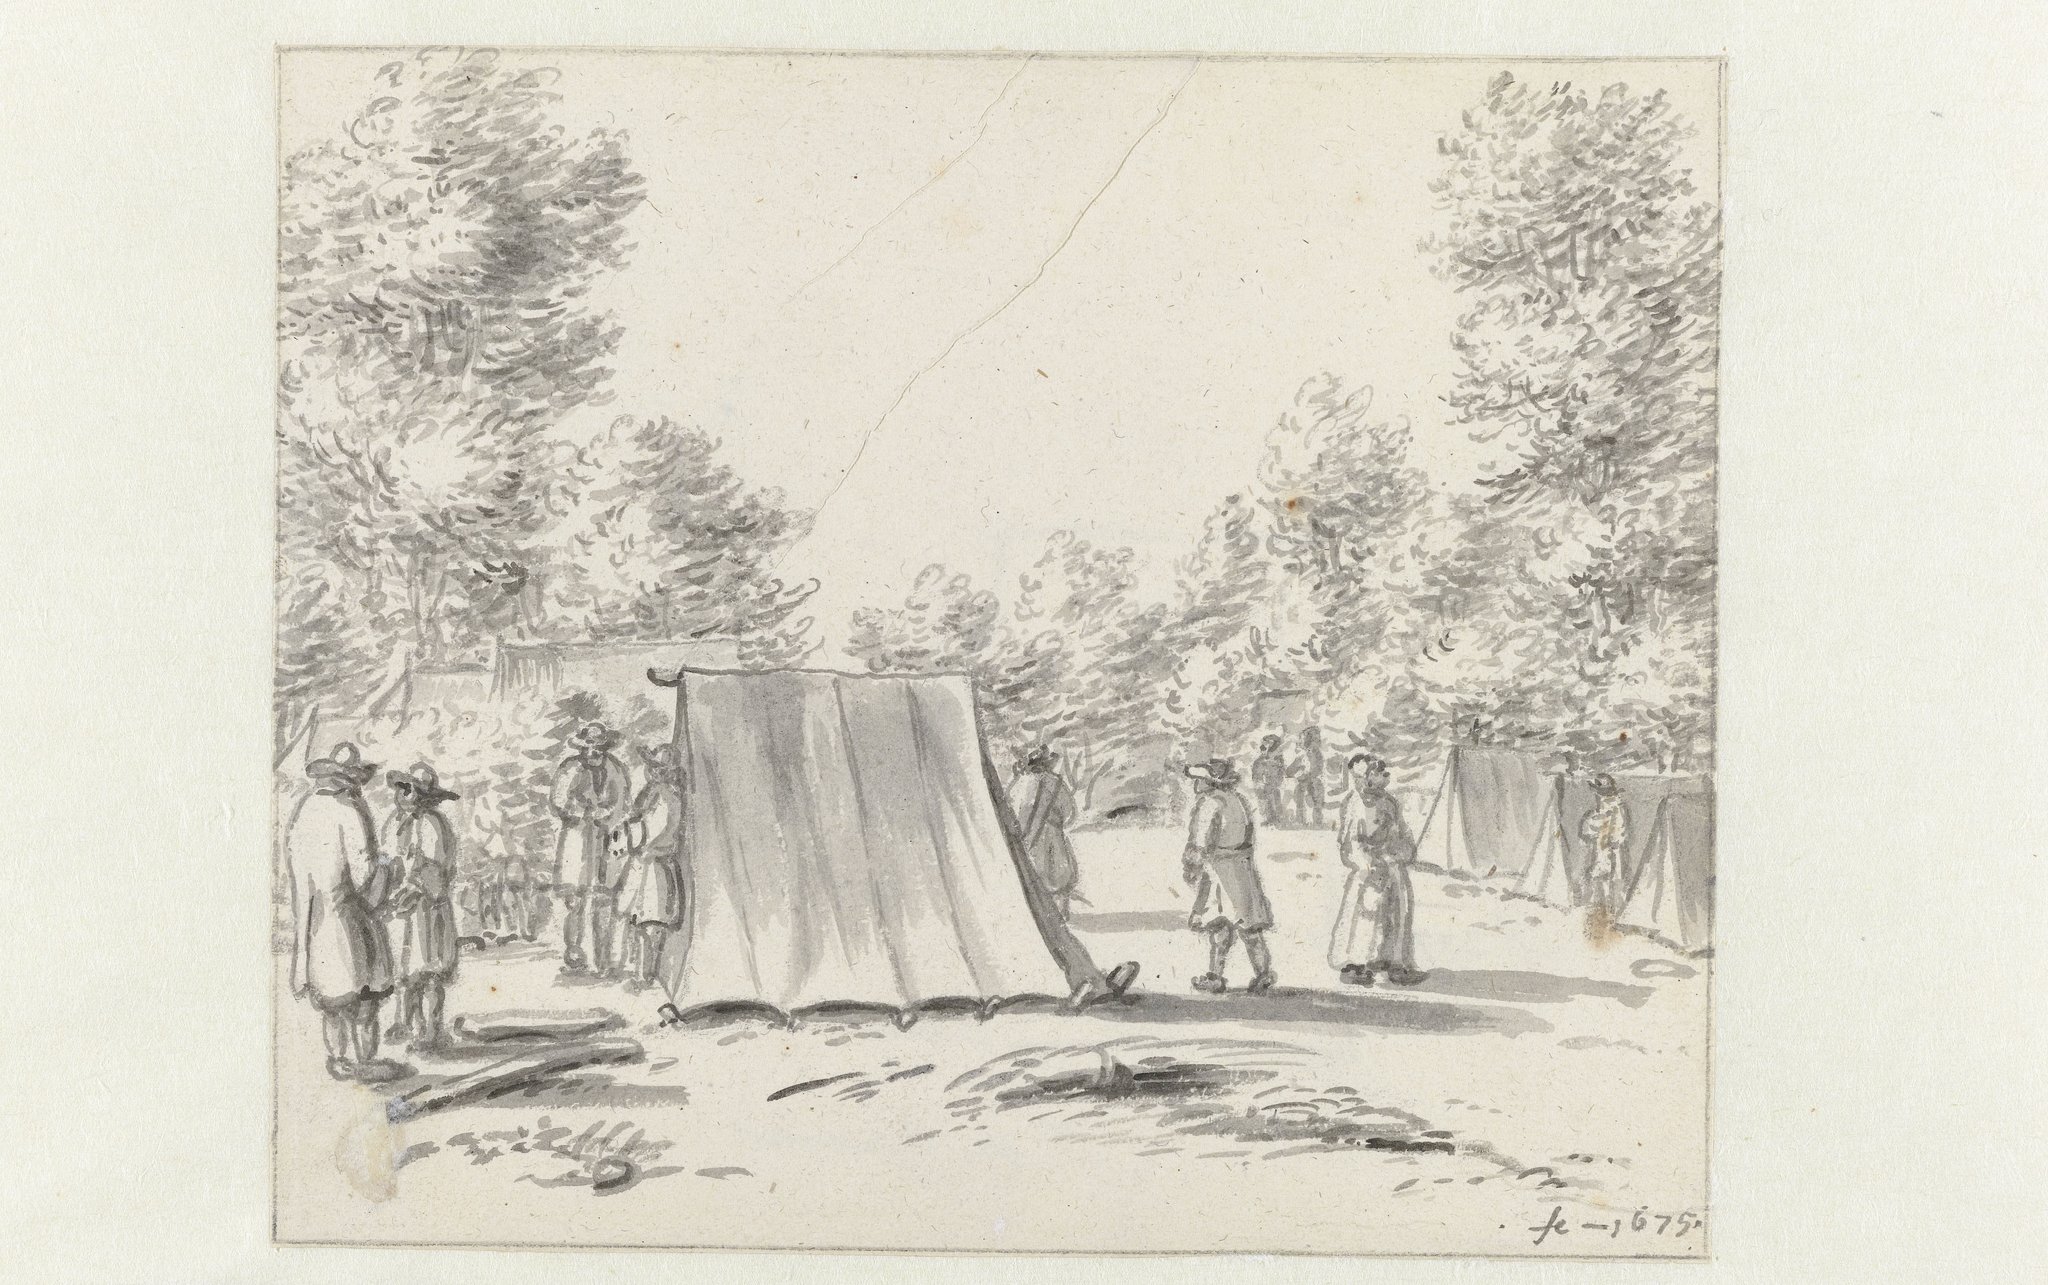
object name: drawing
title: View of an Encampment of the Army of Willem III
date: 1675-1725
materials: paper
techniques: brush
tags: the hague, william iii (prince of orange and king of england, scotland, and ireland), (military) camp with tents